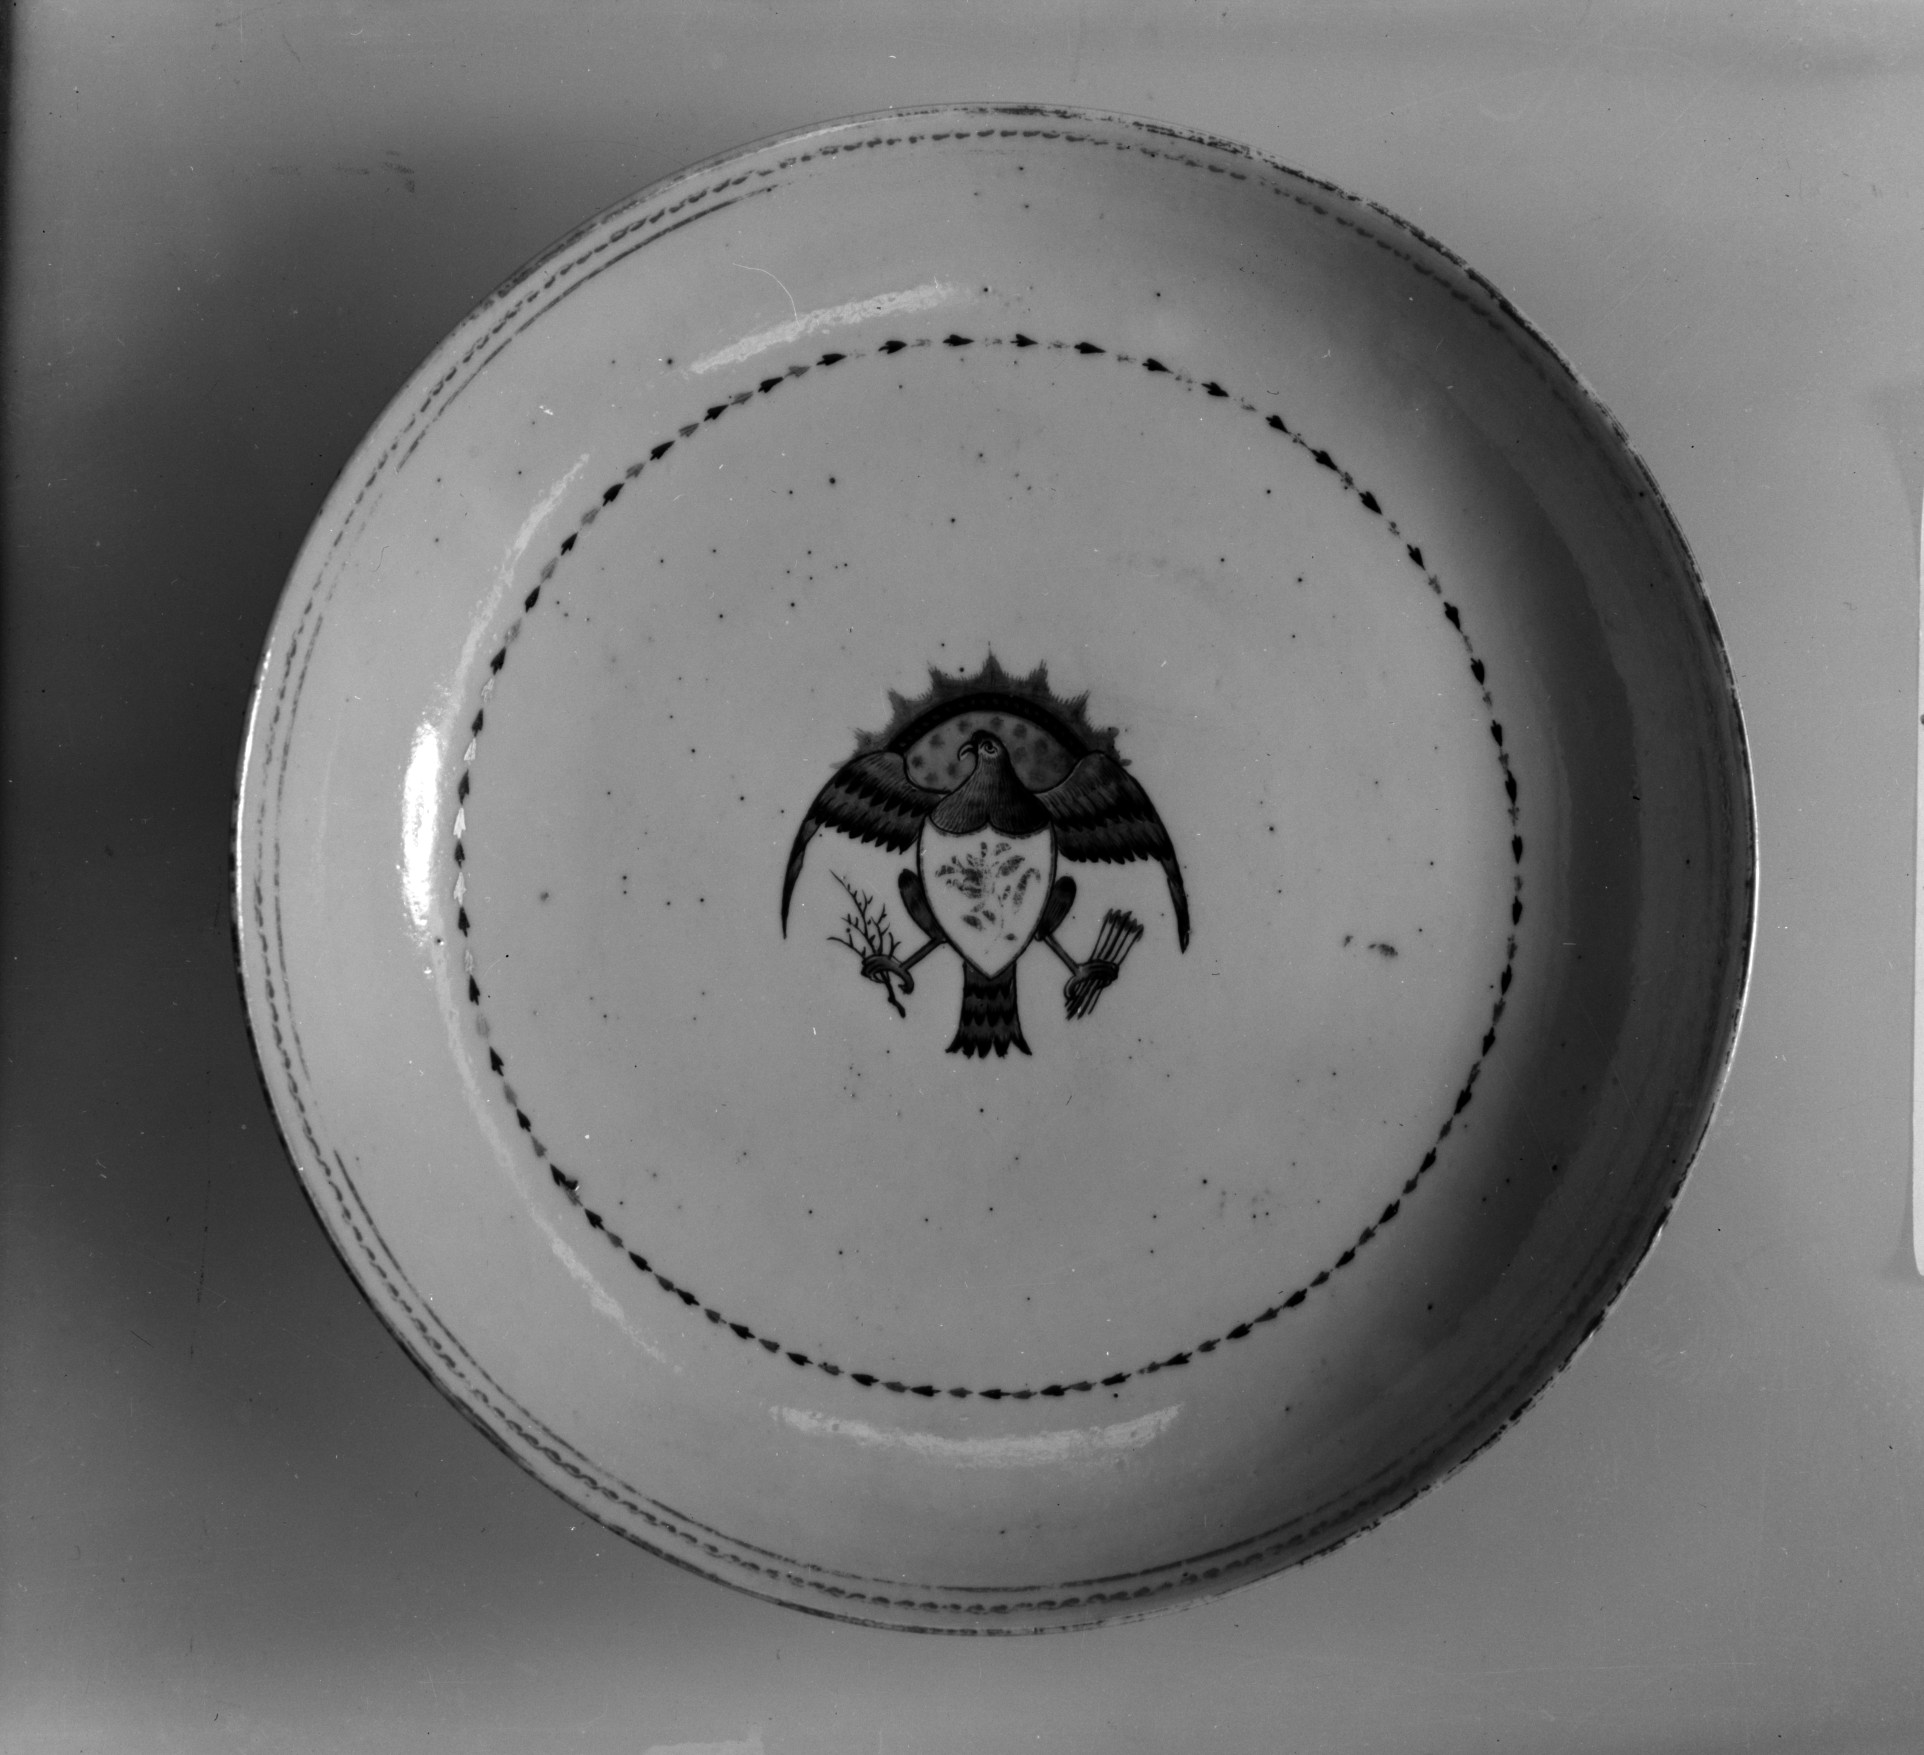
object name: dish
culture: chinese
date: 1800-1815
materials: porcelain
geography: china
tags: eagles